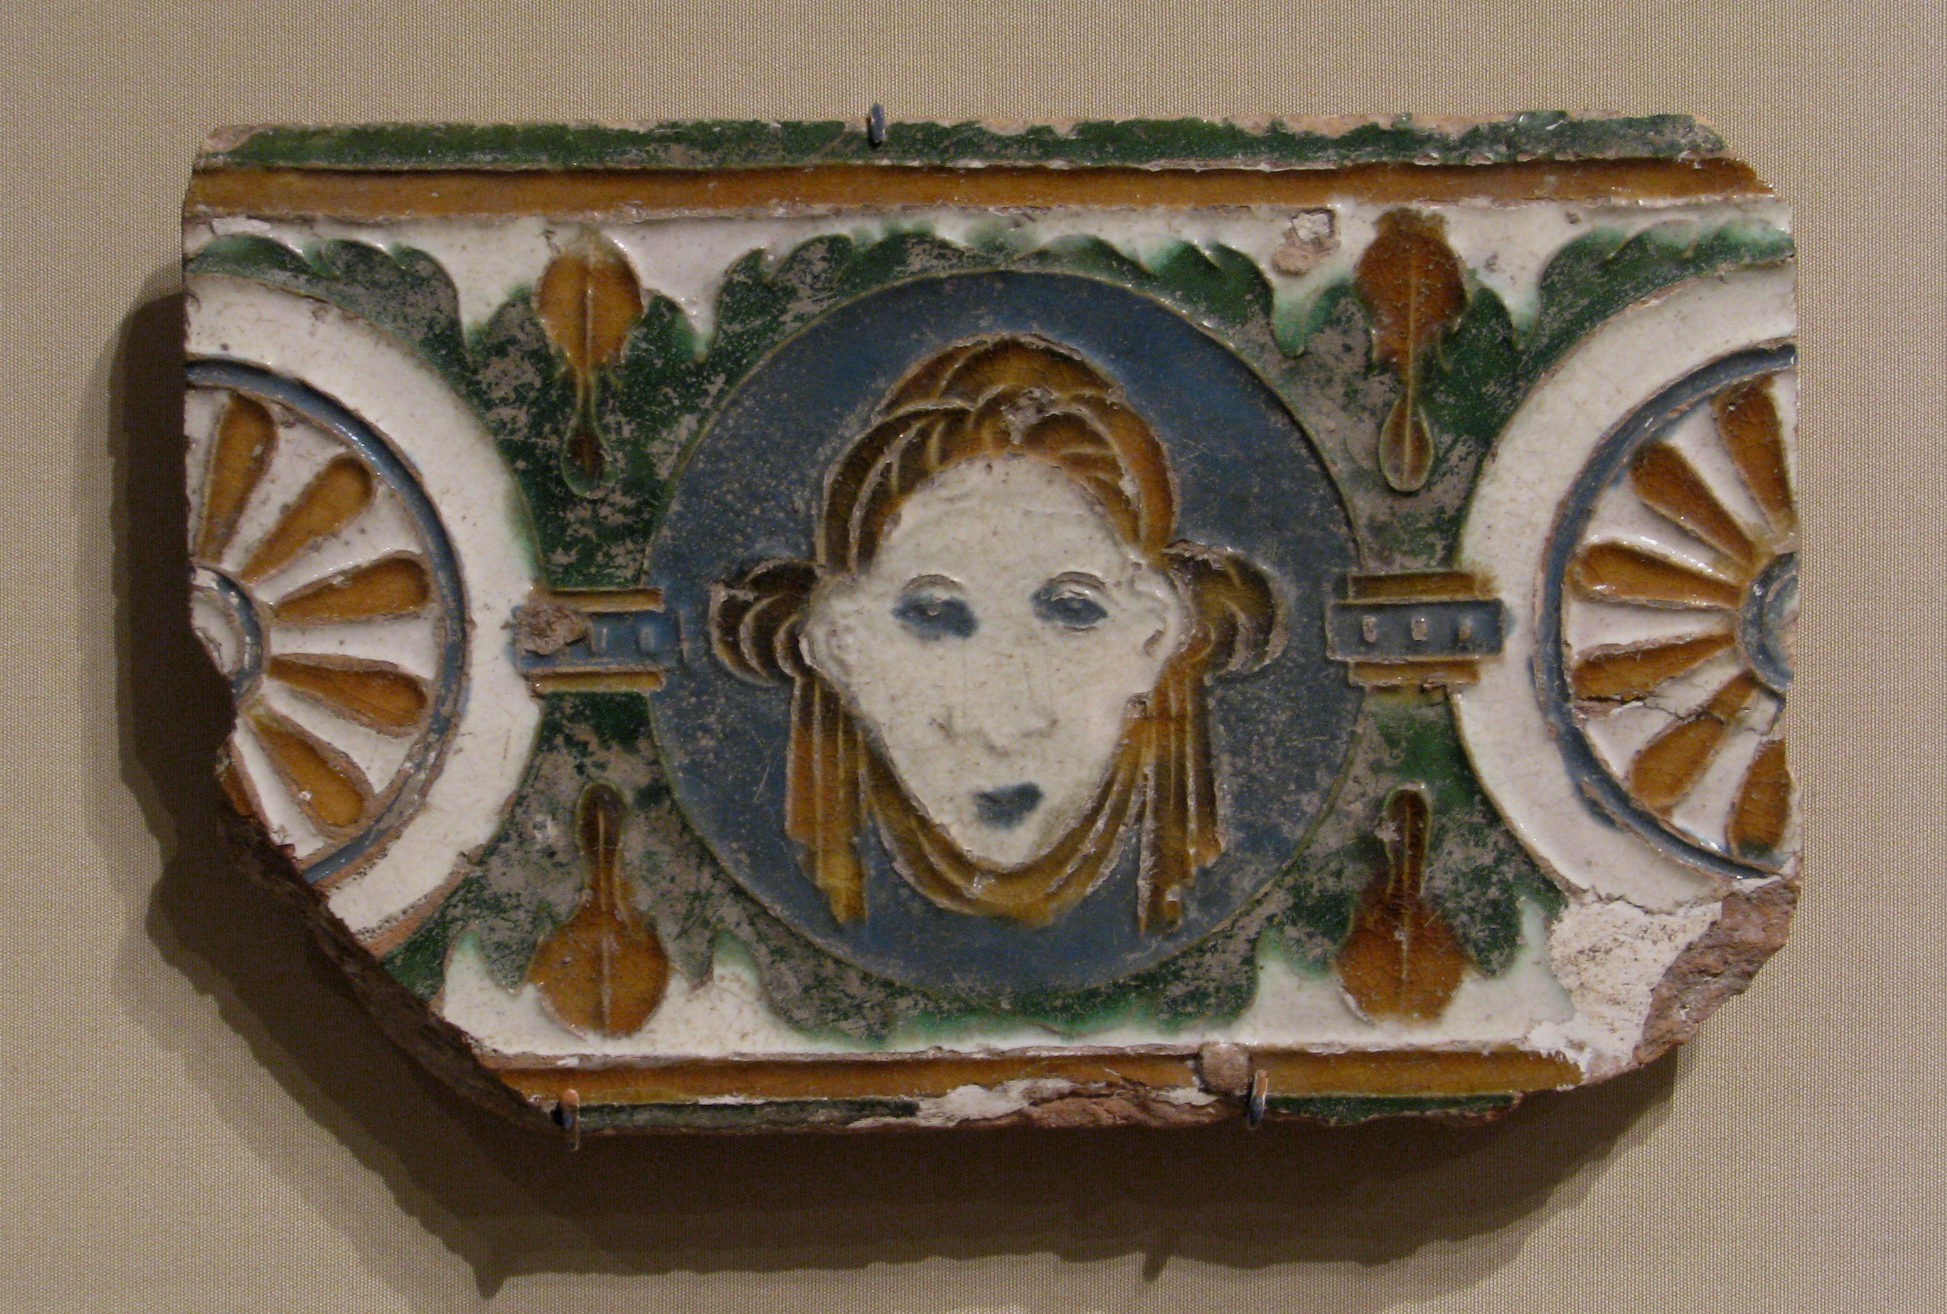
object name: tile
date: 1567-1600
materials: earthenware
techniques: glazing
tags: faces